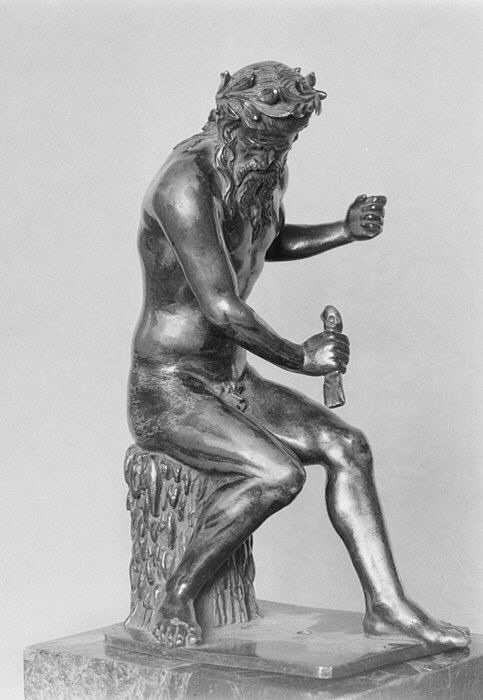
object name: statuette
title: Neptune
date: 1601-1800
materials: bronze, marble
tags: neptune